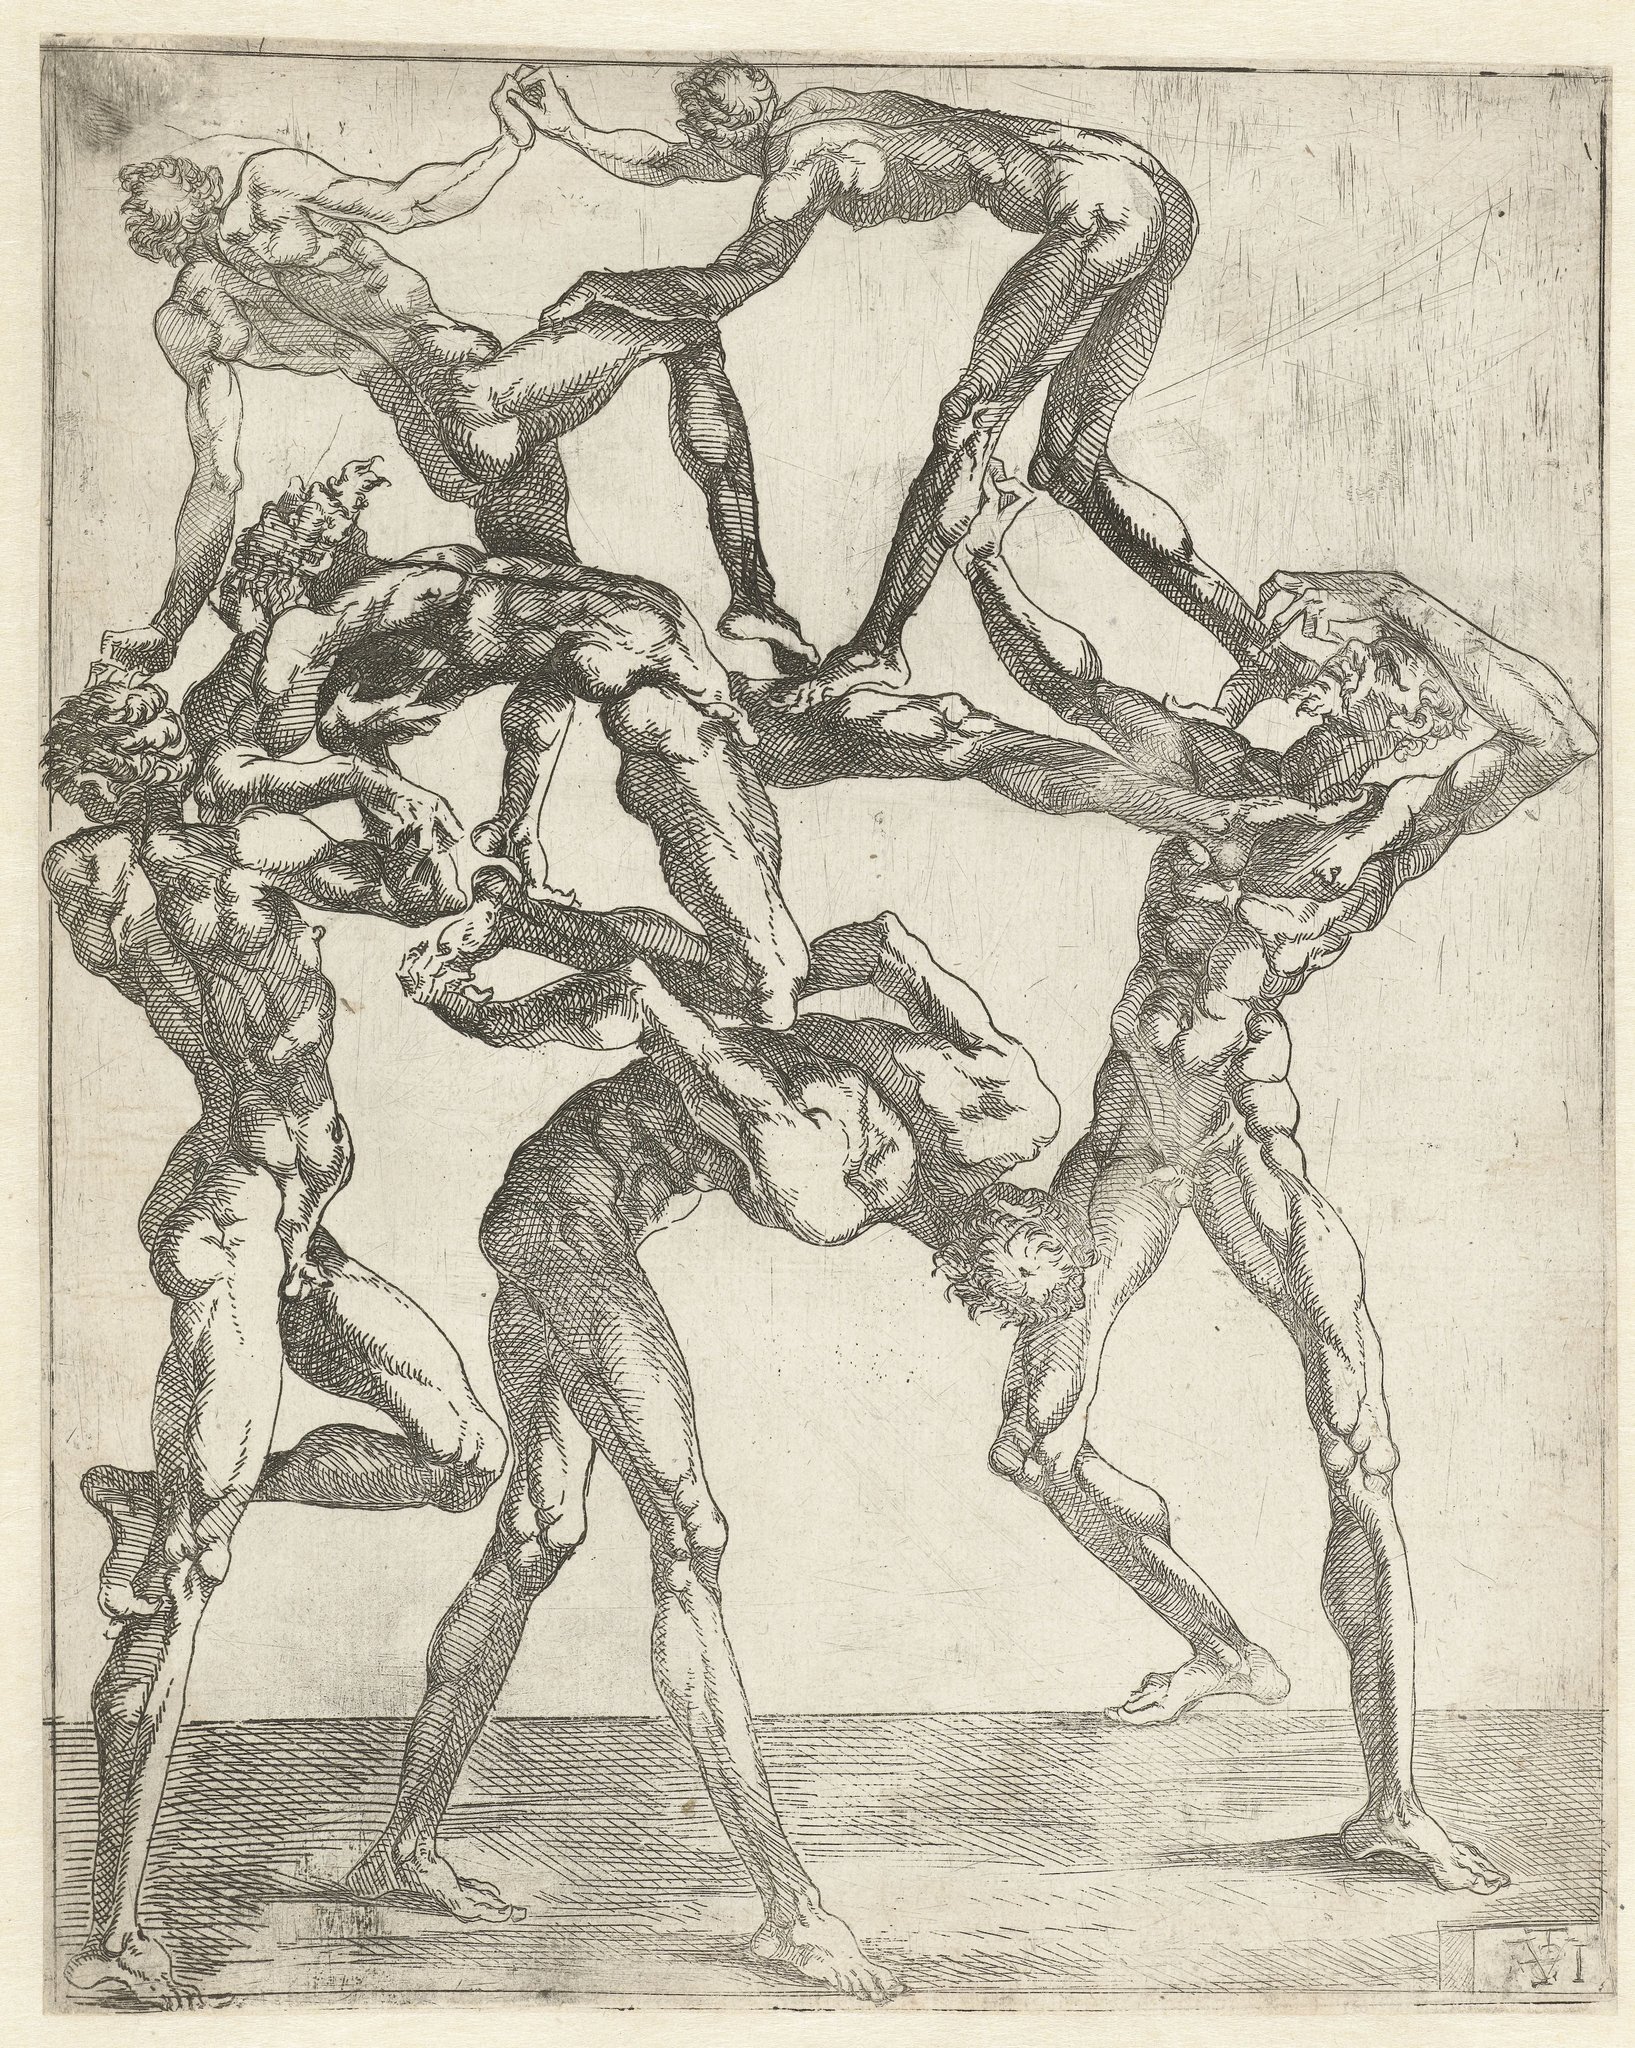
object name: print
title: Piramide van zes mannen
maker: juste de juste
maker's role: print maker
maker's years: 1505-1559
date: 1541-1545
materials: paper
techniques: etching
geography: france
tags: some other movements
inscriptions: collector's mark: Lugt 2760, collector's mark: Lugt 2228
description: In de Dictionary of Engravers (Londen 1785-6, dl. 19 en 29, p. 104 en354) toegeschreven aan Lorich en Antonio Tempesta.